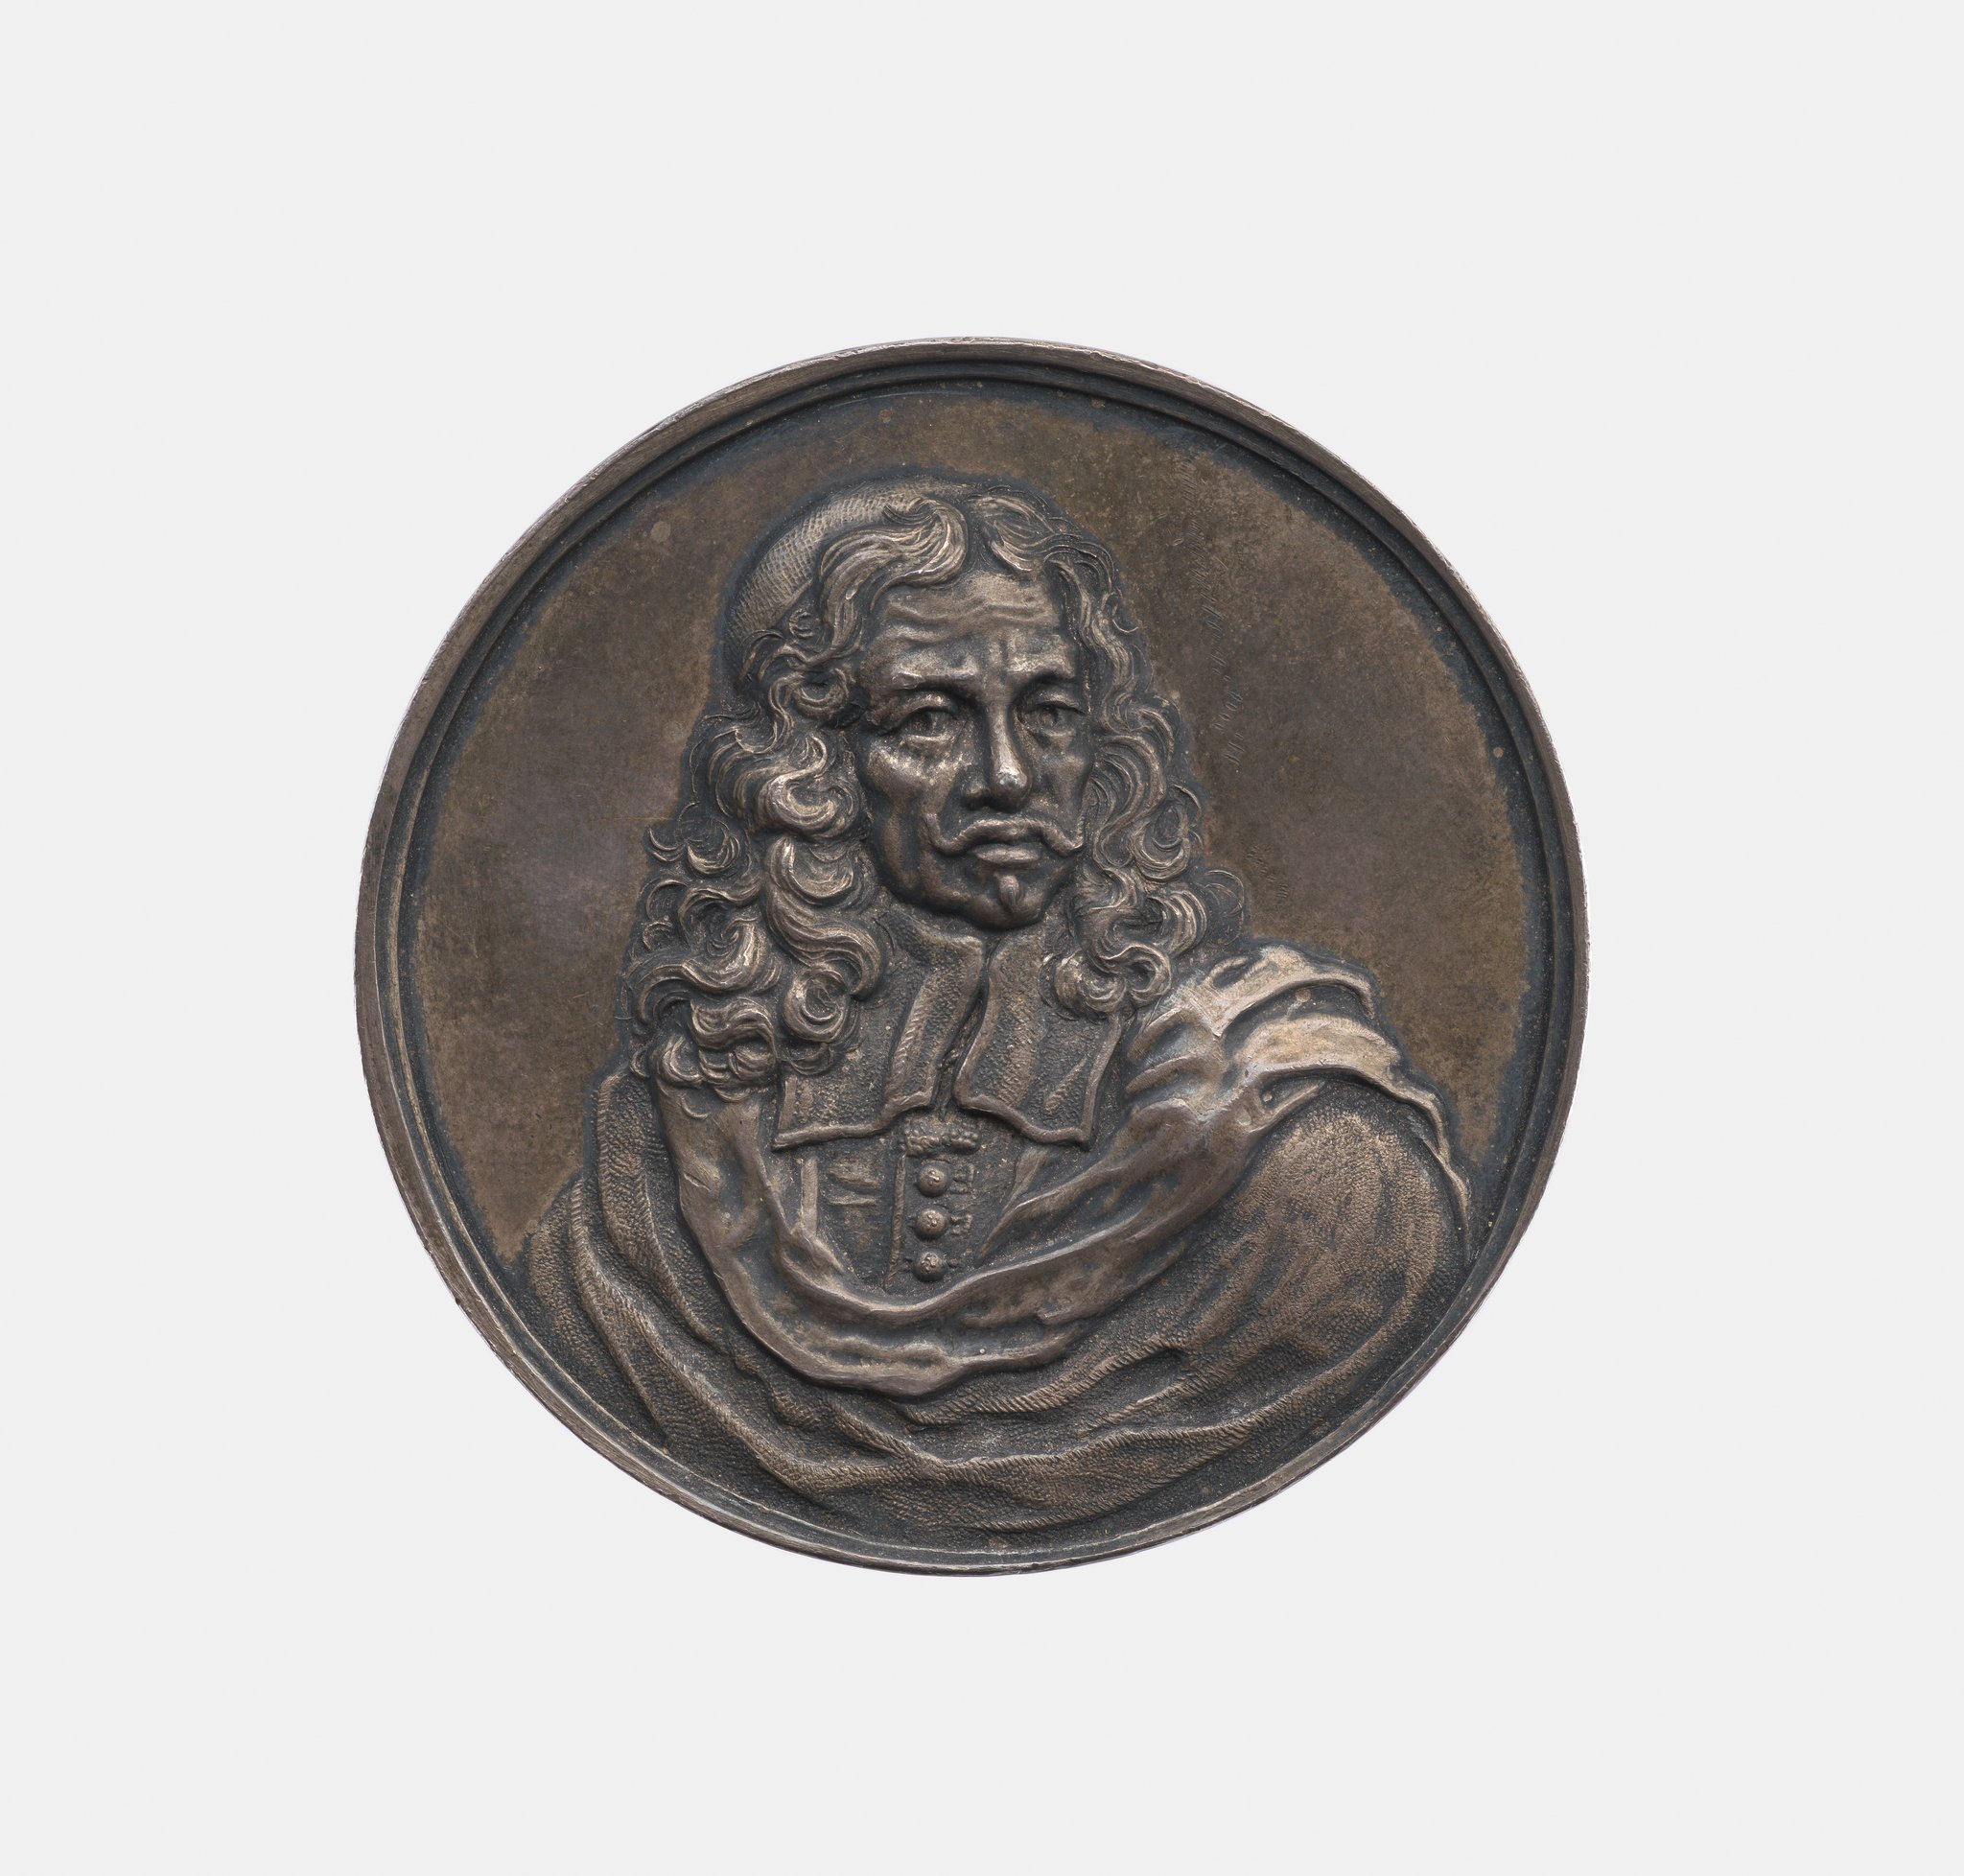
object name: medal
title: John Hevelius, Astronomer in Danzig 1611-87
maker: johann hoehn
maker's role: artist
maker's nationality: german, danzig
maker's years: 1637-1693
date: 1687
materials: silver